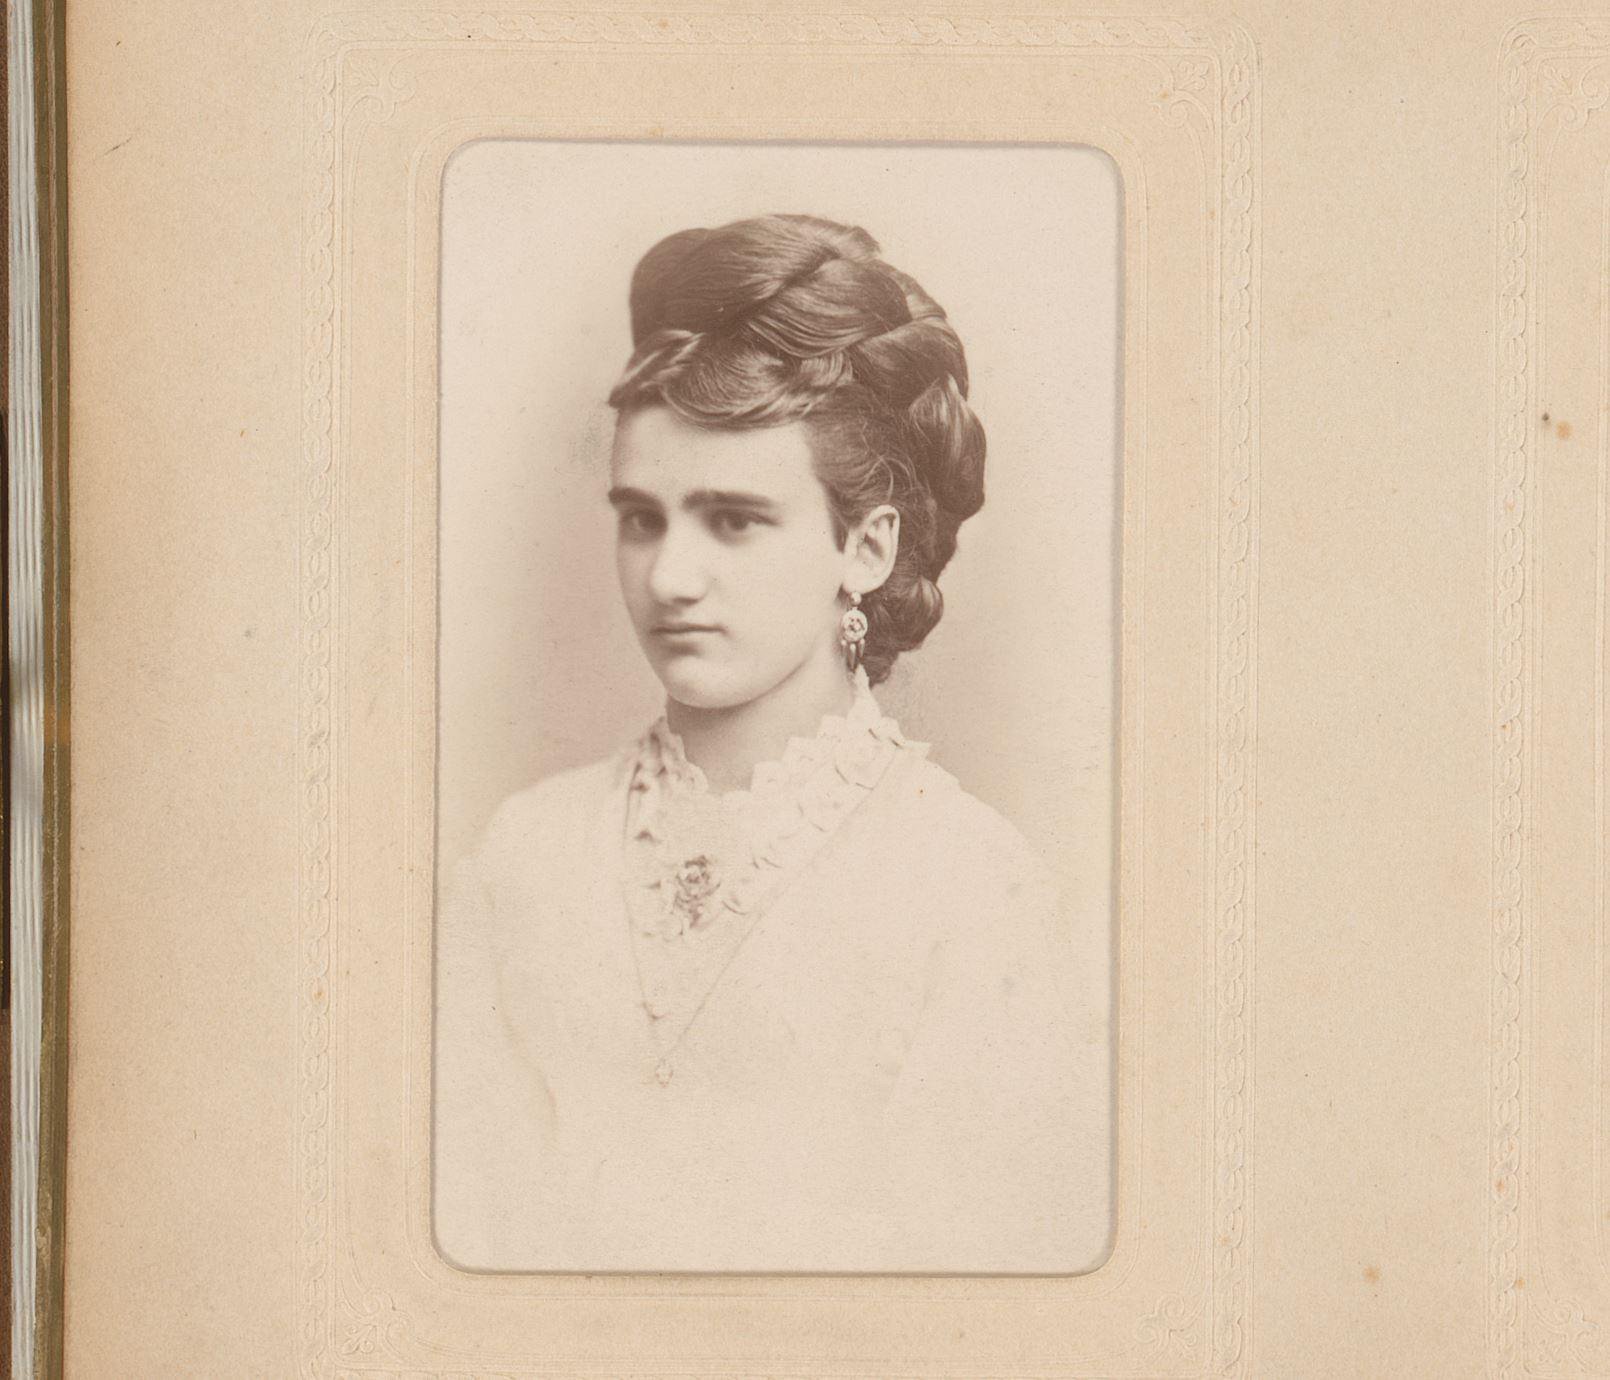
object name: album leaf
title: Portret van een jonge vrouw met oorbellen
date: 1875-1895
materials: cardboard, photographic support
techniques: albumen print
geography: vienna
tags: adolescent, young woman, maiden, historical persons - bb - woman, ear-rings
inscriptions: inscription: ‘ADÈLE/ k.k. Hof-Fotografin/ GRABEN 19/ Hôtel Müller/ und/ Praterstrasse 18,/ Hôtel de l'Europe./ Vervielfältigung vorbehalten./ Bei Nachbestellungen belieben die No... anzugeben.’